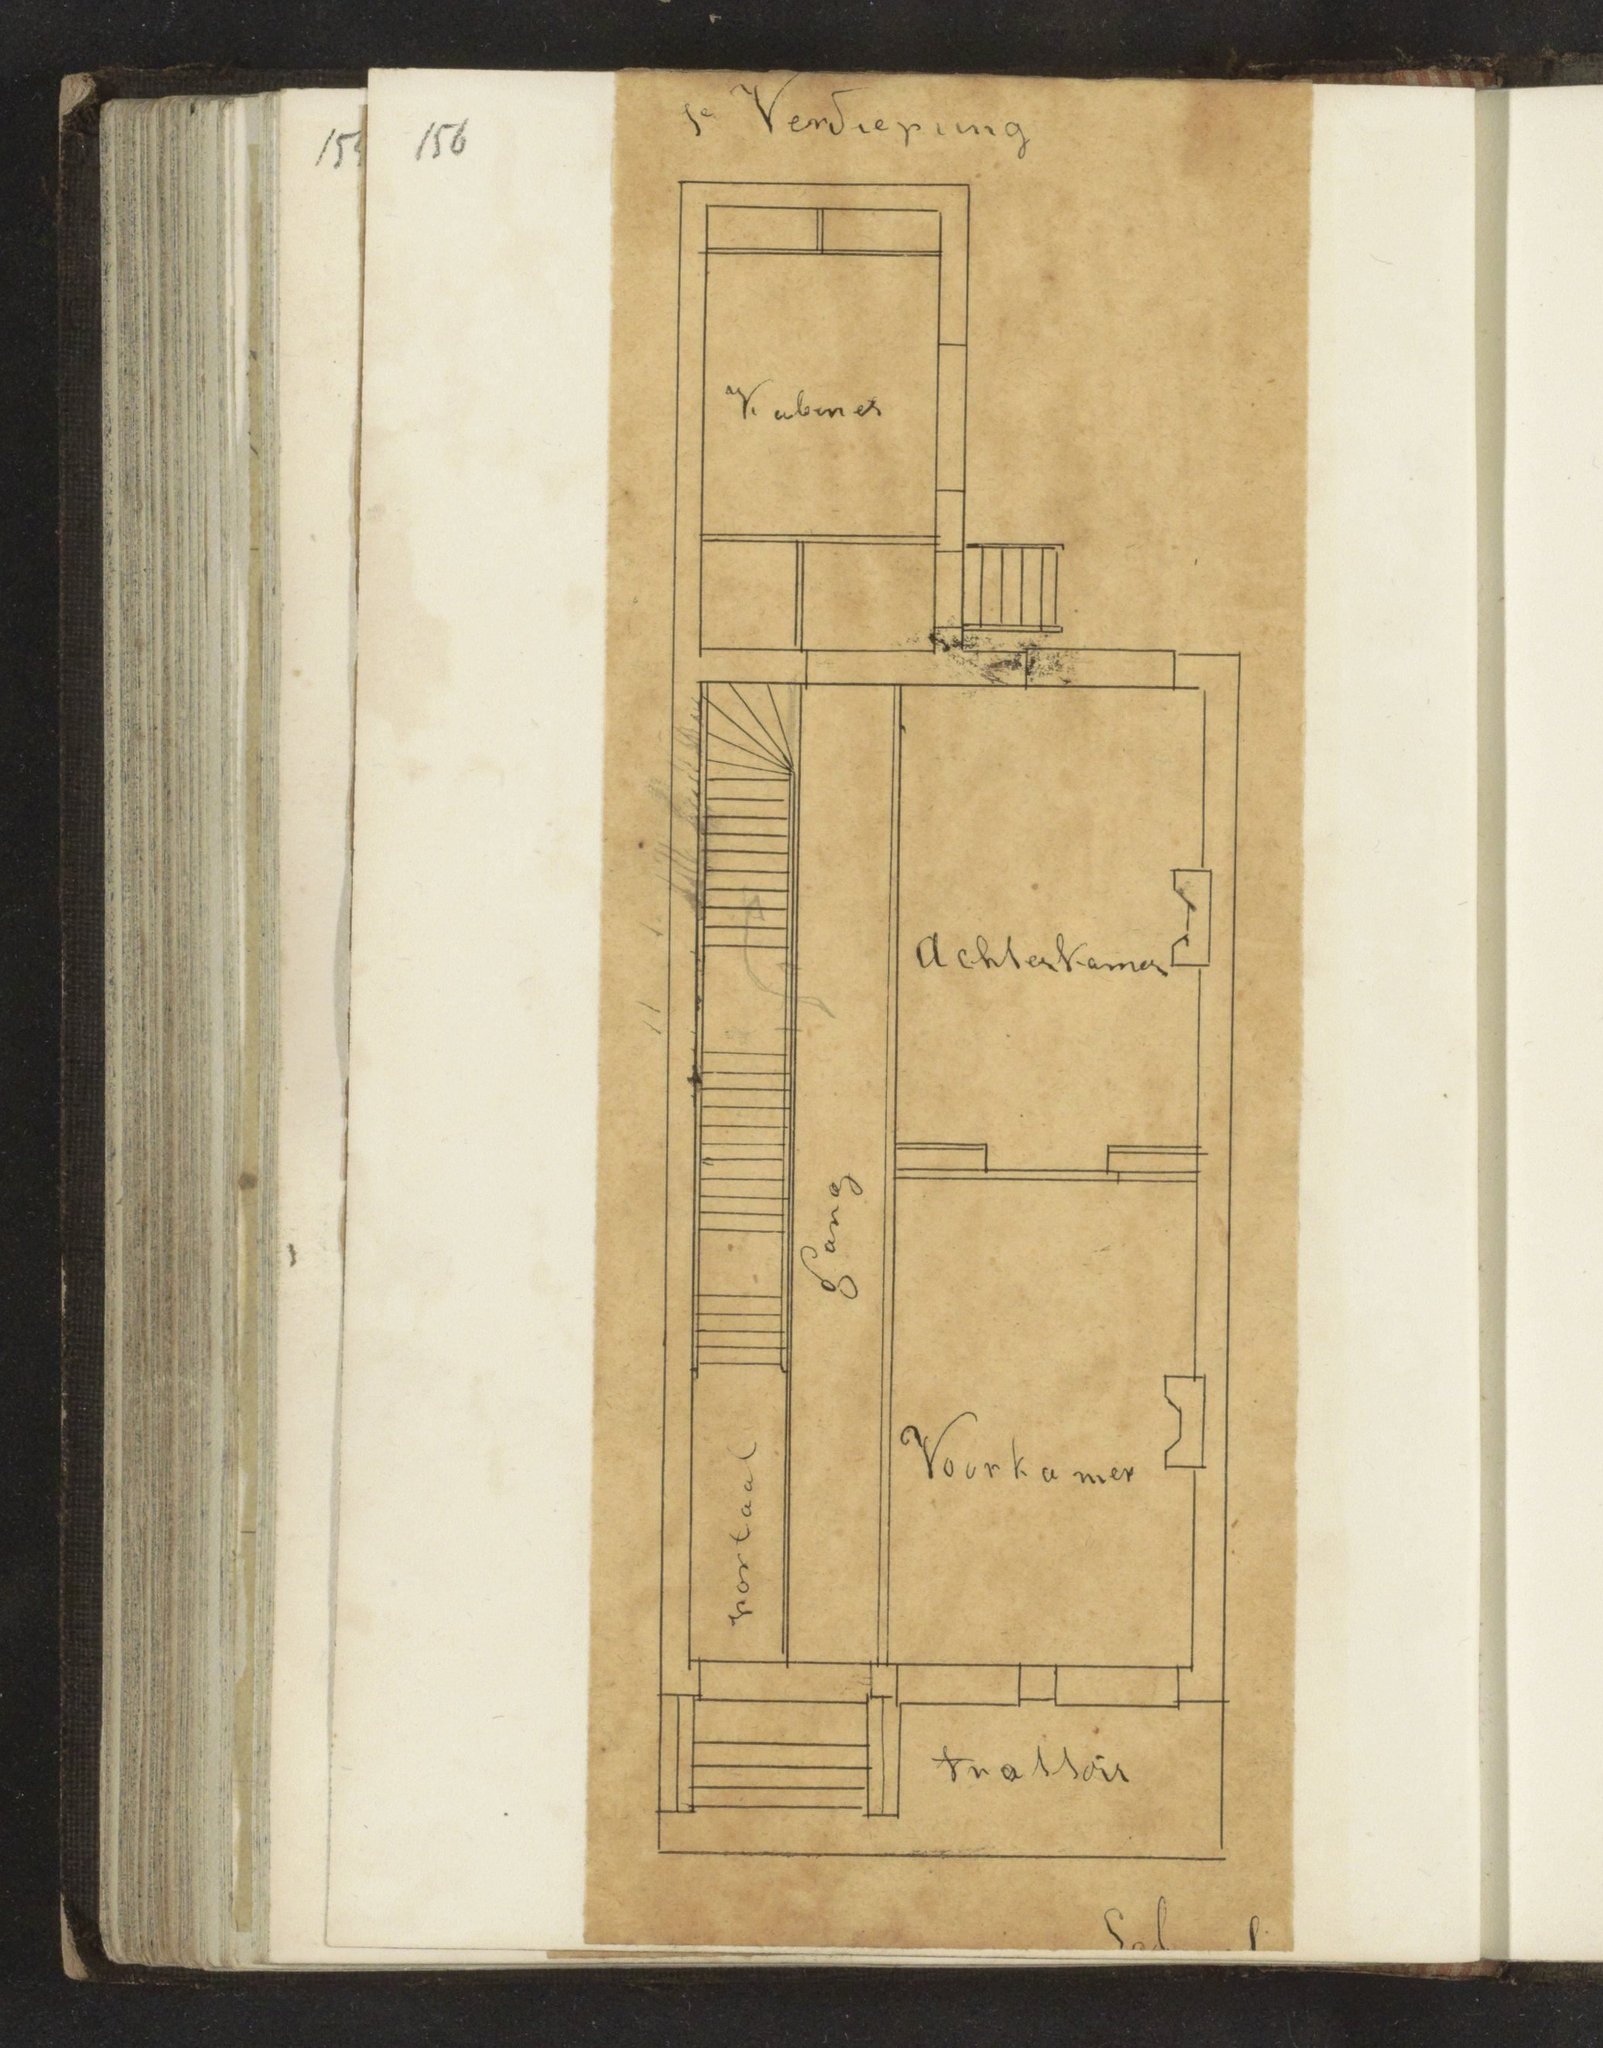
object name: sketchbook leaf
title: Plattegrond van de eerste verdieping van een woonhuis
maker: willem springer jr.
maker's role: draughtsman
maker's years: 1815-1907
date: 1864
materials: ink, paper, pencil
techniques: pen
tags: plan ~ architecture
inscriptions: annotation: ‘1e Verdieping/ Kabinet/ Achterkamer/ ...’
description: Pagina 156 uit een schetsboek met 164 pagina's.